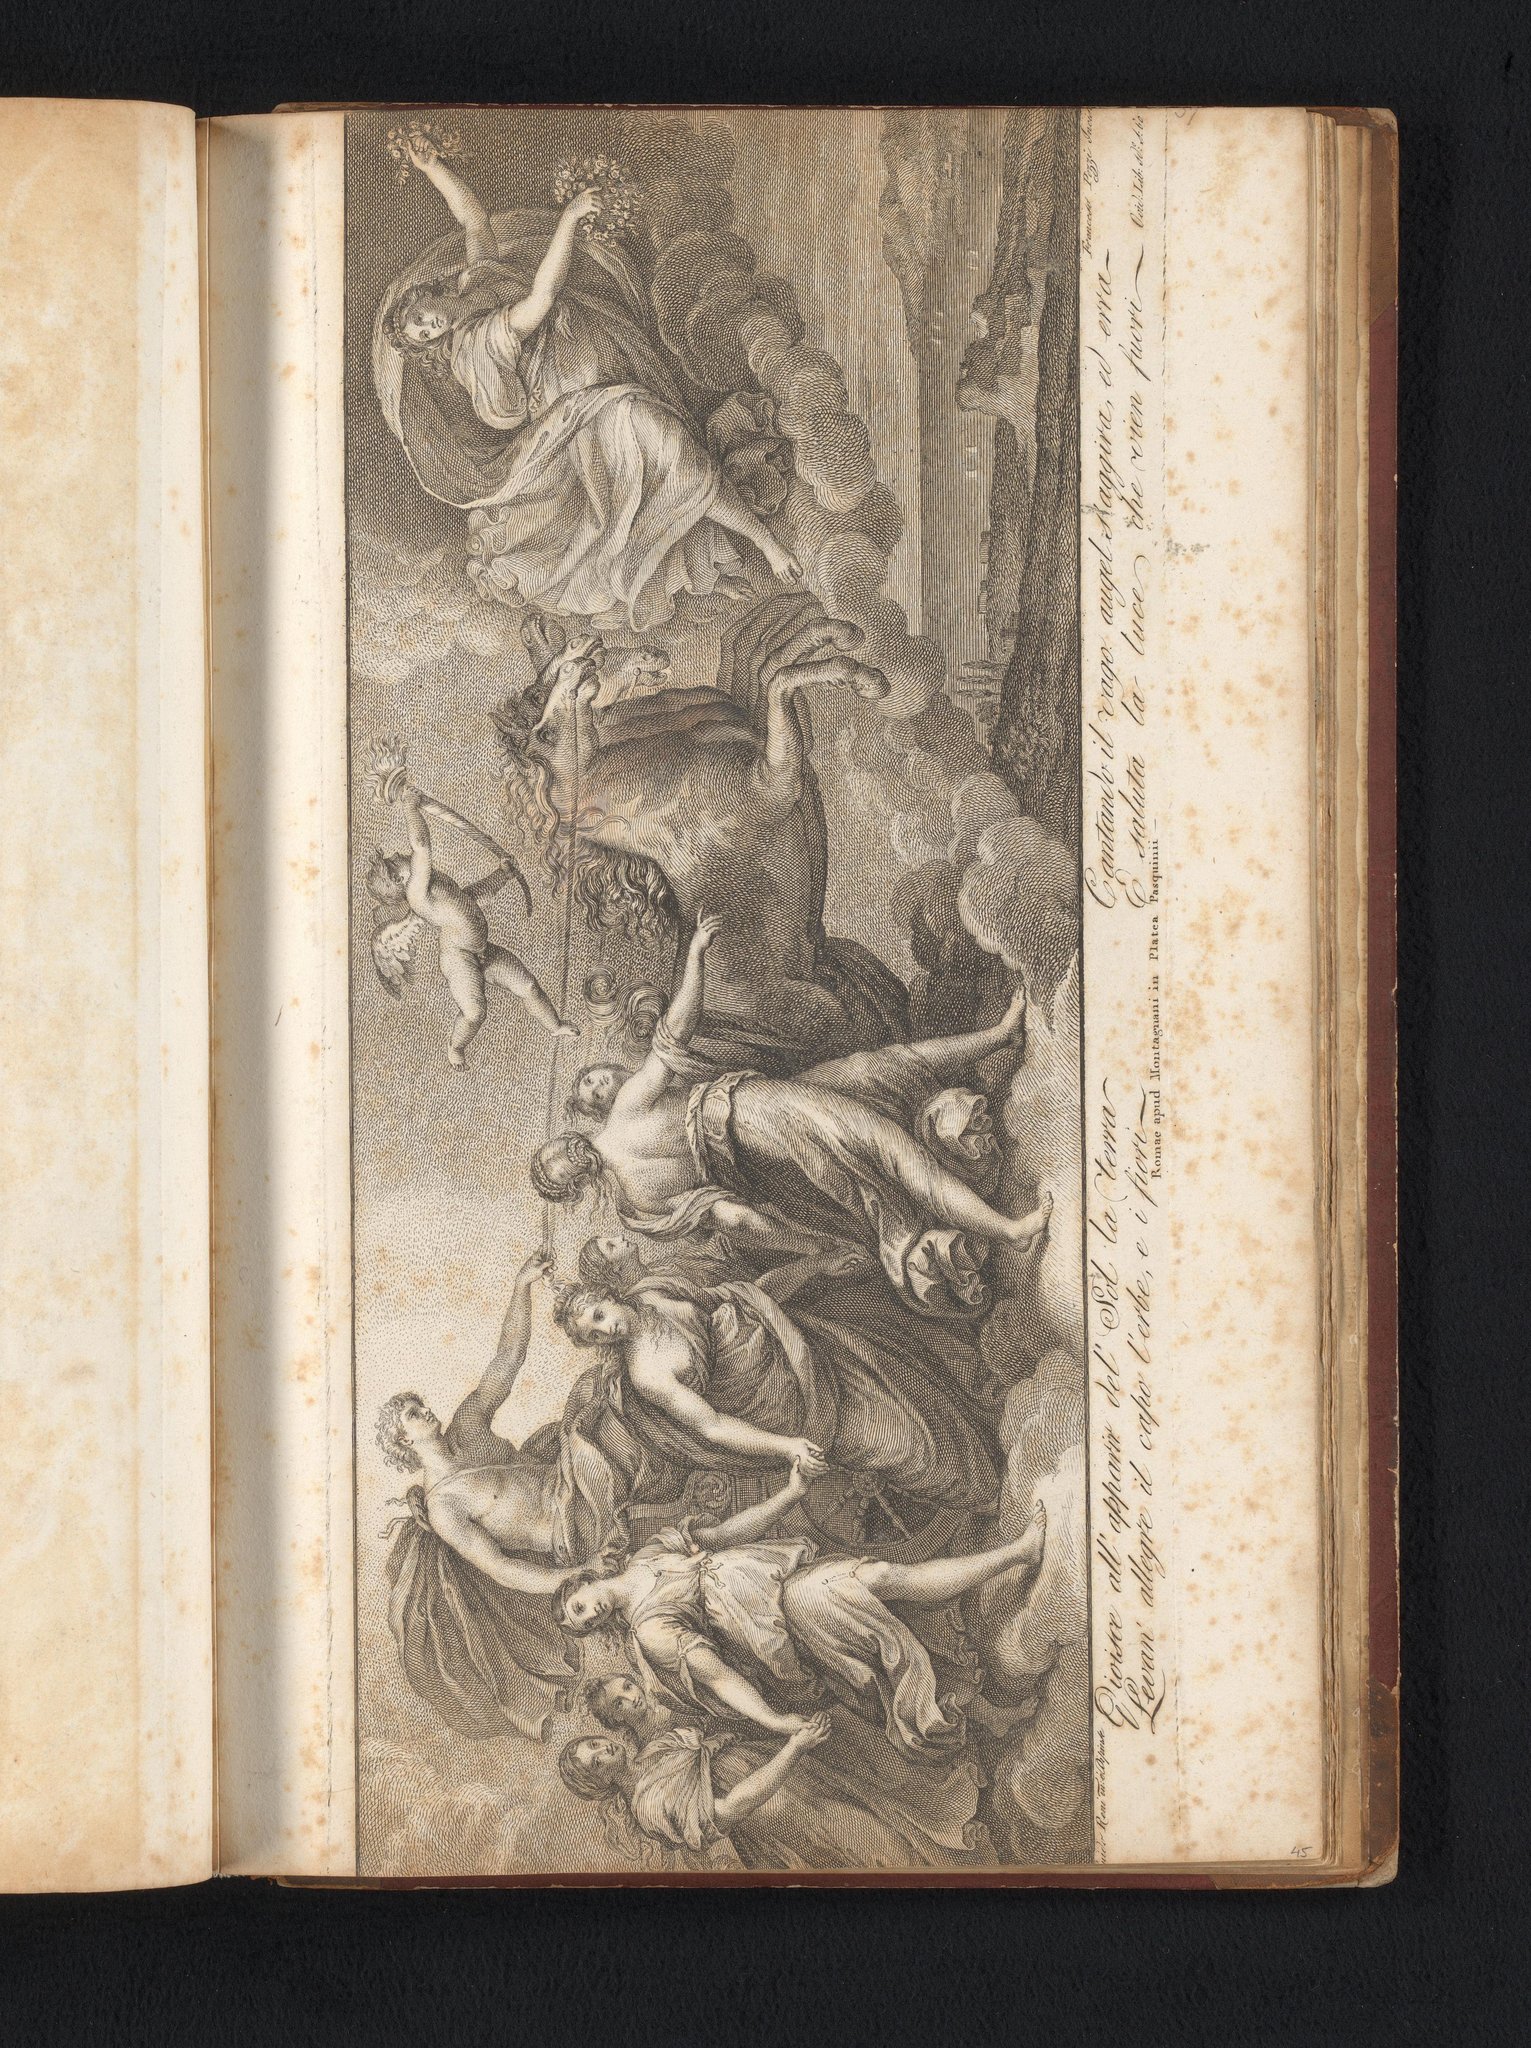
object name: print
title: Aurora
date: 1750-1816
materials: paper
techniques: engraving, etching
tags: triumph of aurora: in her chariot drawn by two (sometimes four) horses, and possibly scattering flowers; aurora's victory over the night; 'carro dell'aurora' (ripa)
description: Ingeplakte prent naar de fresco van Aurora. Onderdeel van het tweede van twee albums met ingeplakte prenten en tekeningen te dienen als tekenvoorbeelden.